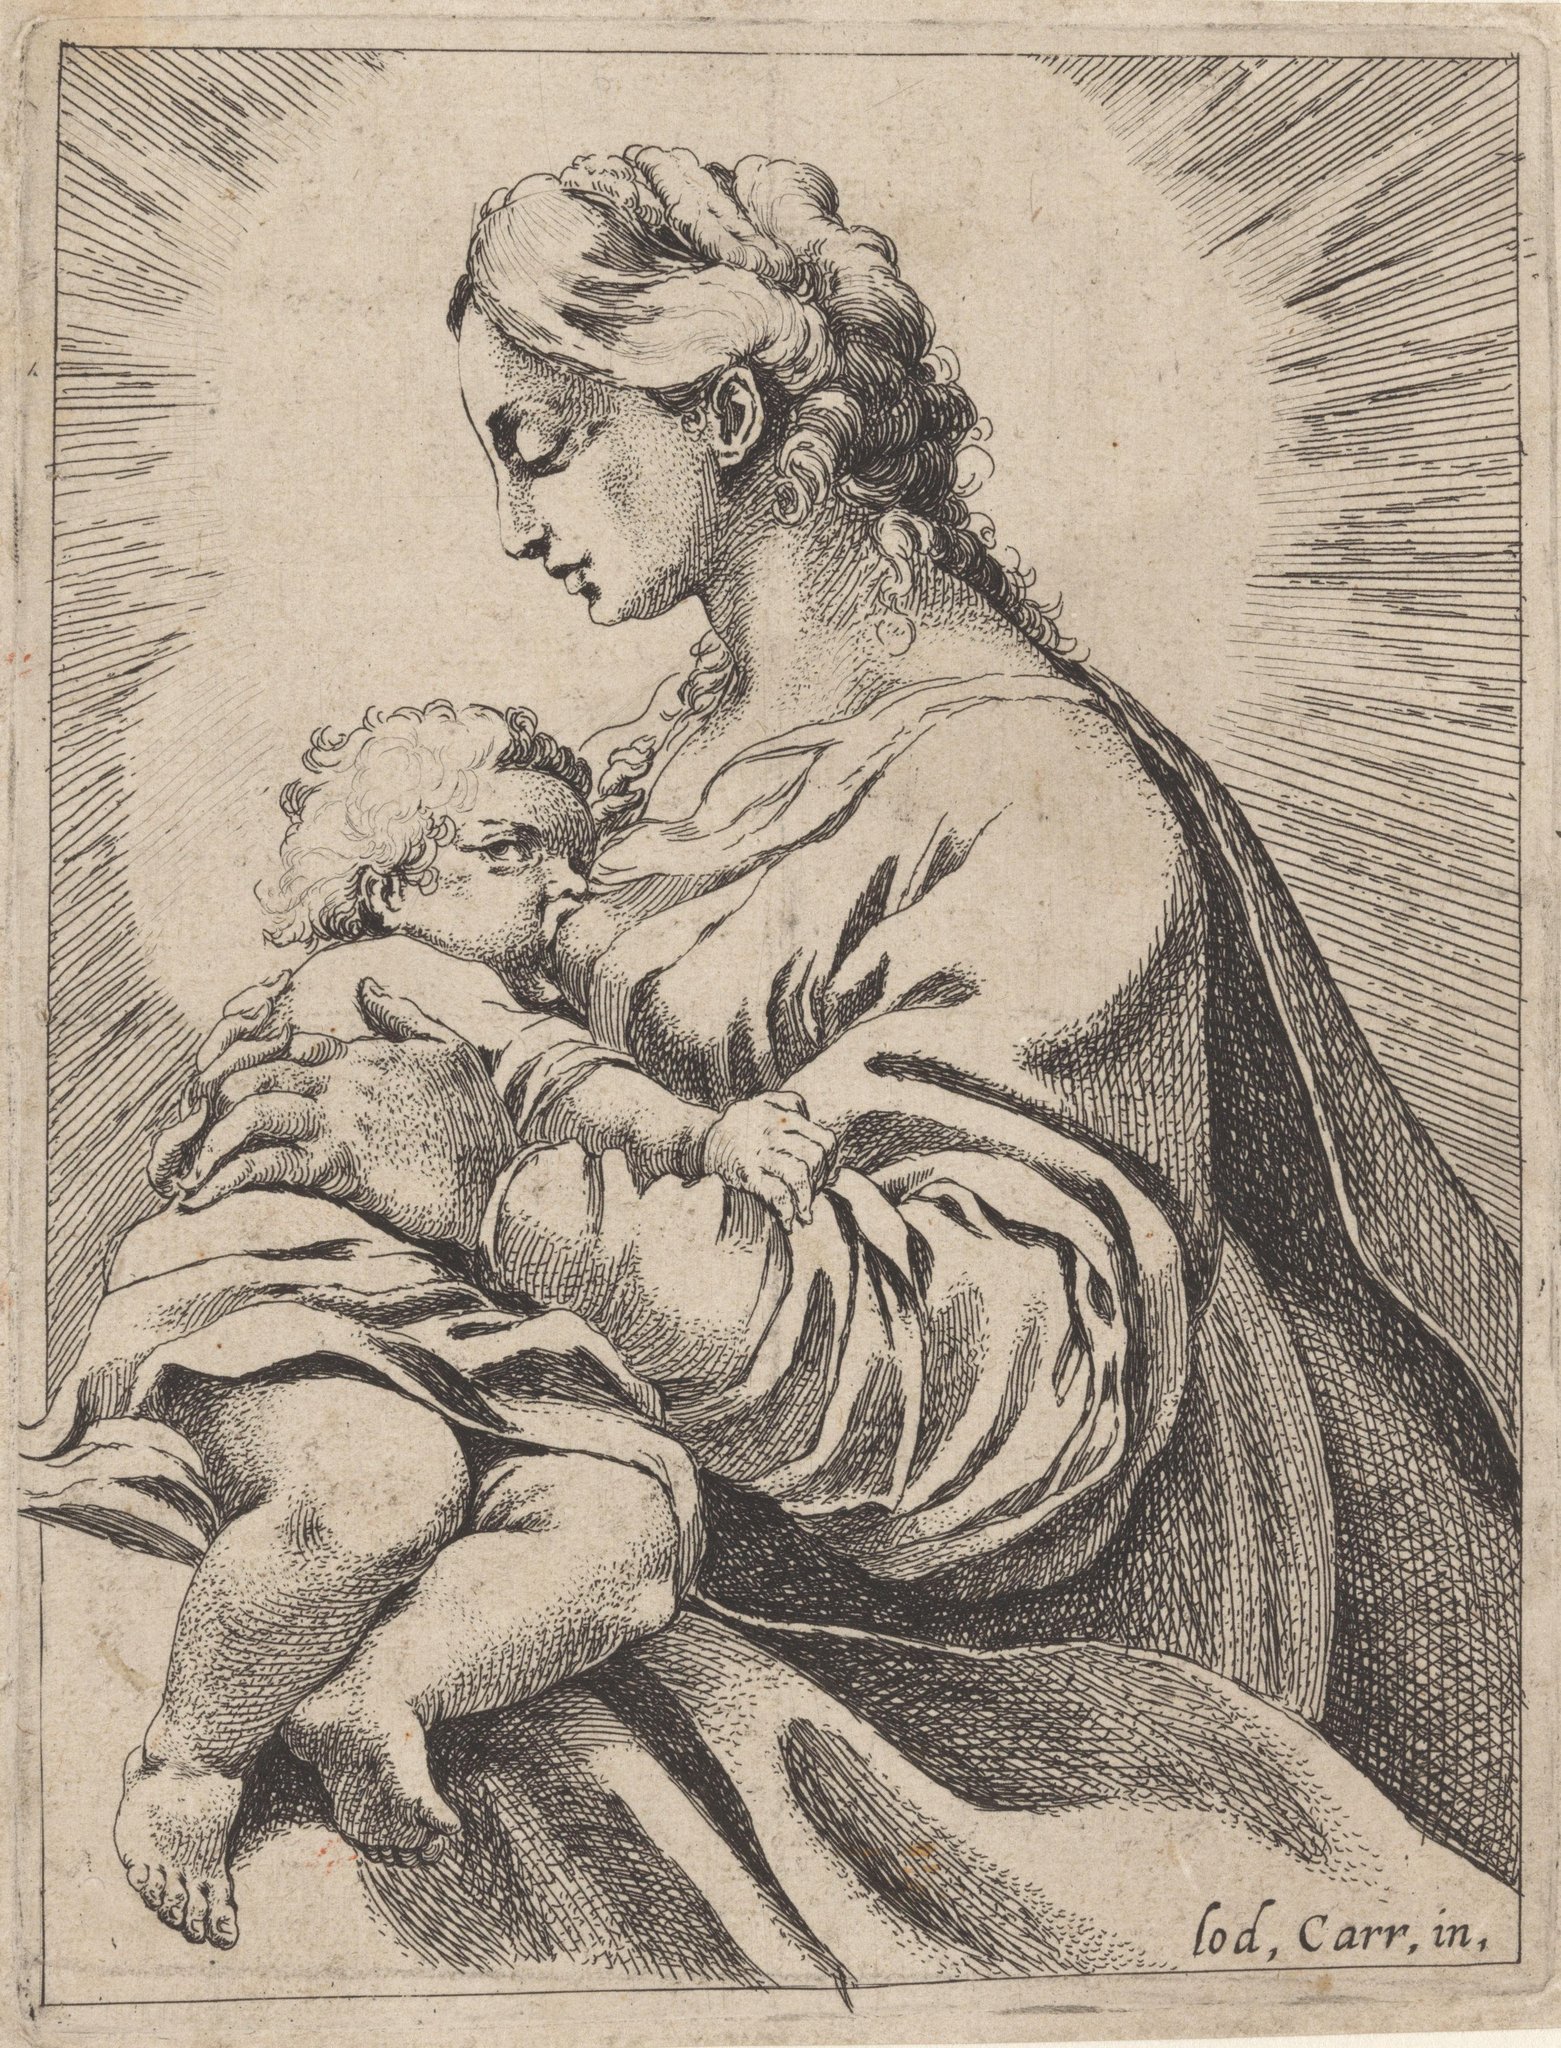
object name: print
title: Maria het Christuskind voedend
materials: paper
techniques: etching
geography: italy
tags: madonna: i.e. mary with the christ-child, christ-child suckling, or beginning to suckle, e.g. mary uncovering her breast ~ madonna-representations, 'madonna dell'umiltà' (usually mary suckling the christ-child while sitting on the ground)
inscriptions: collector's mark: Lugt 240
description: Maria zit met het Christuskind op schoot en geeft hem de borst.